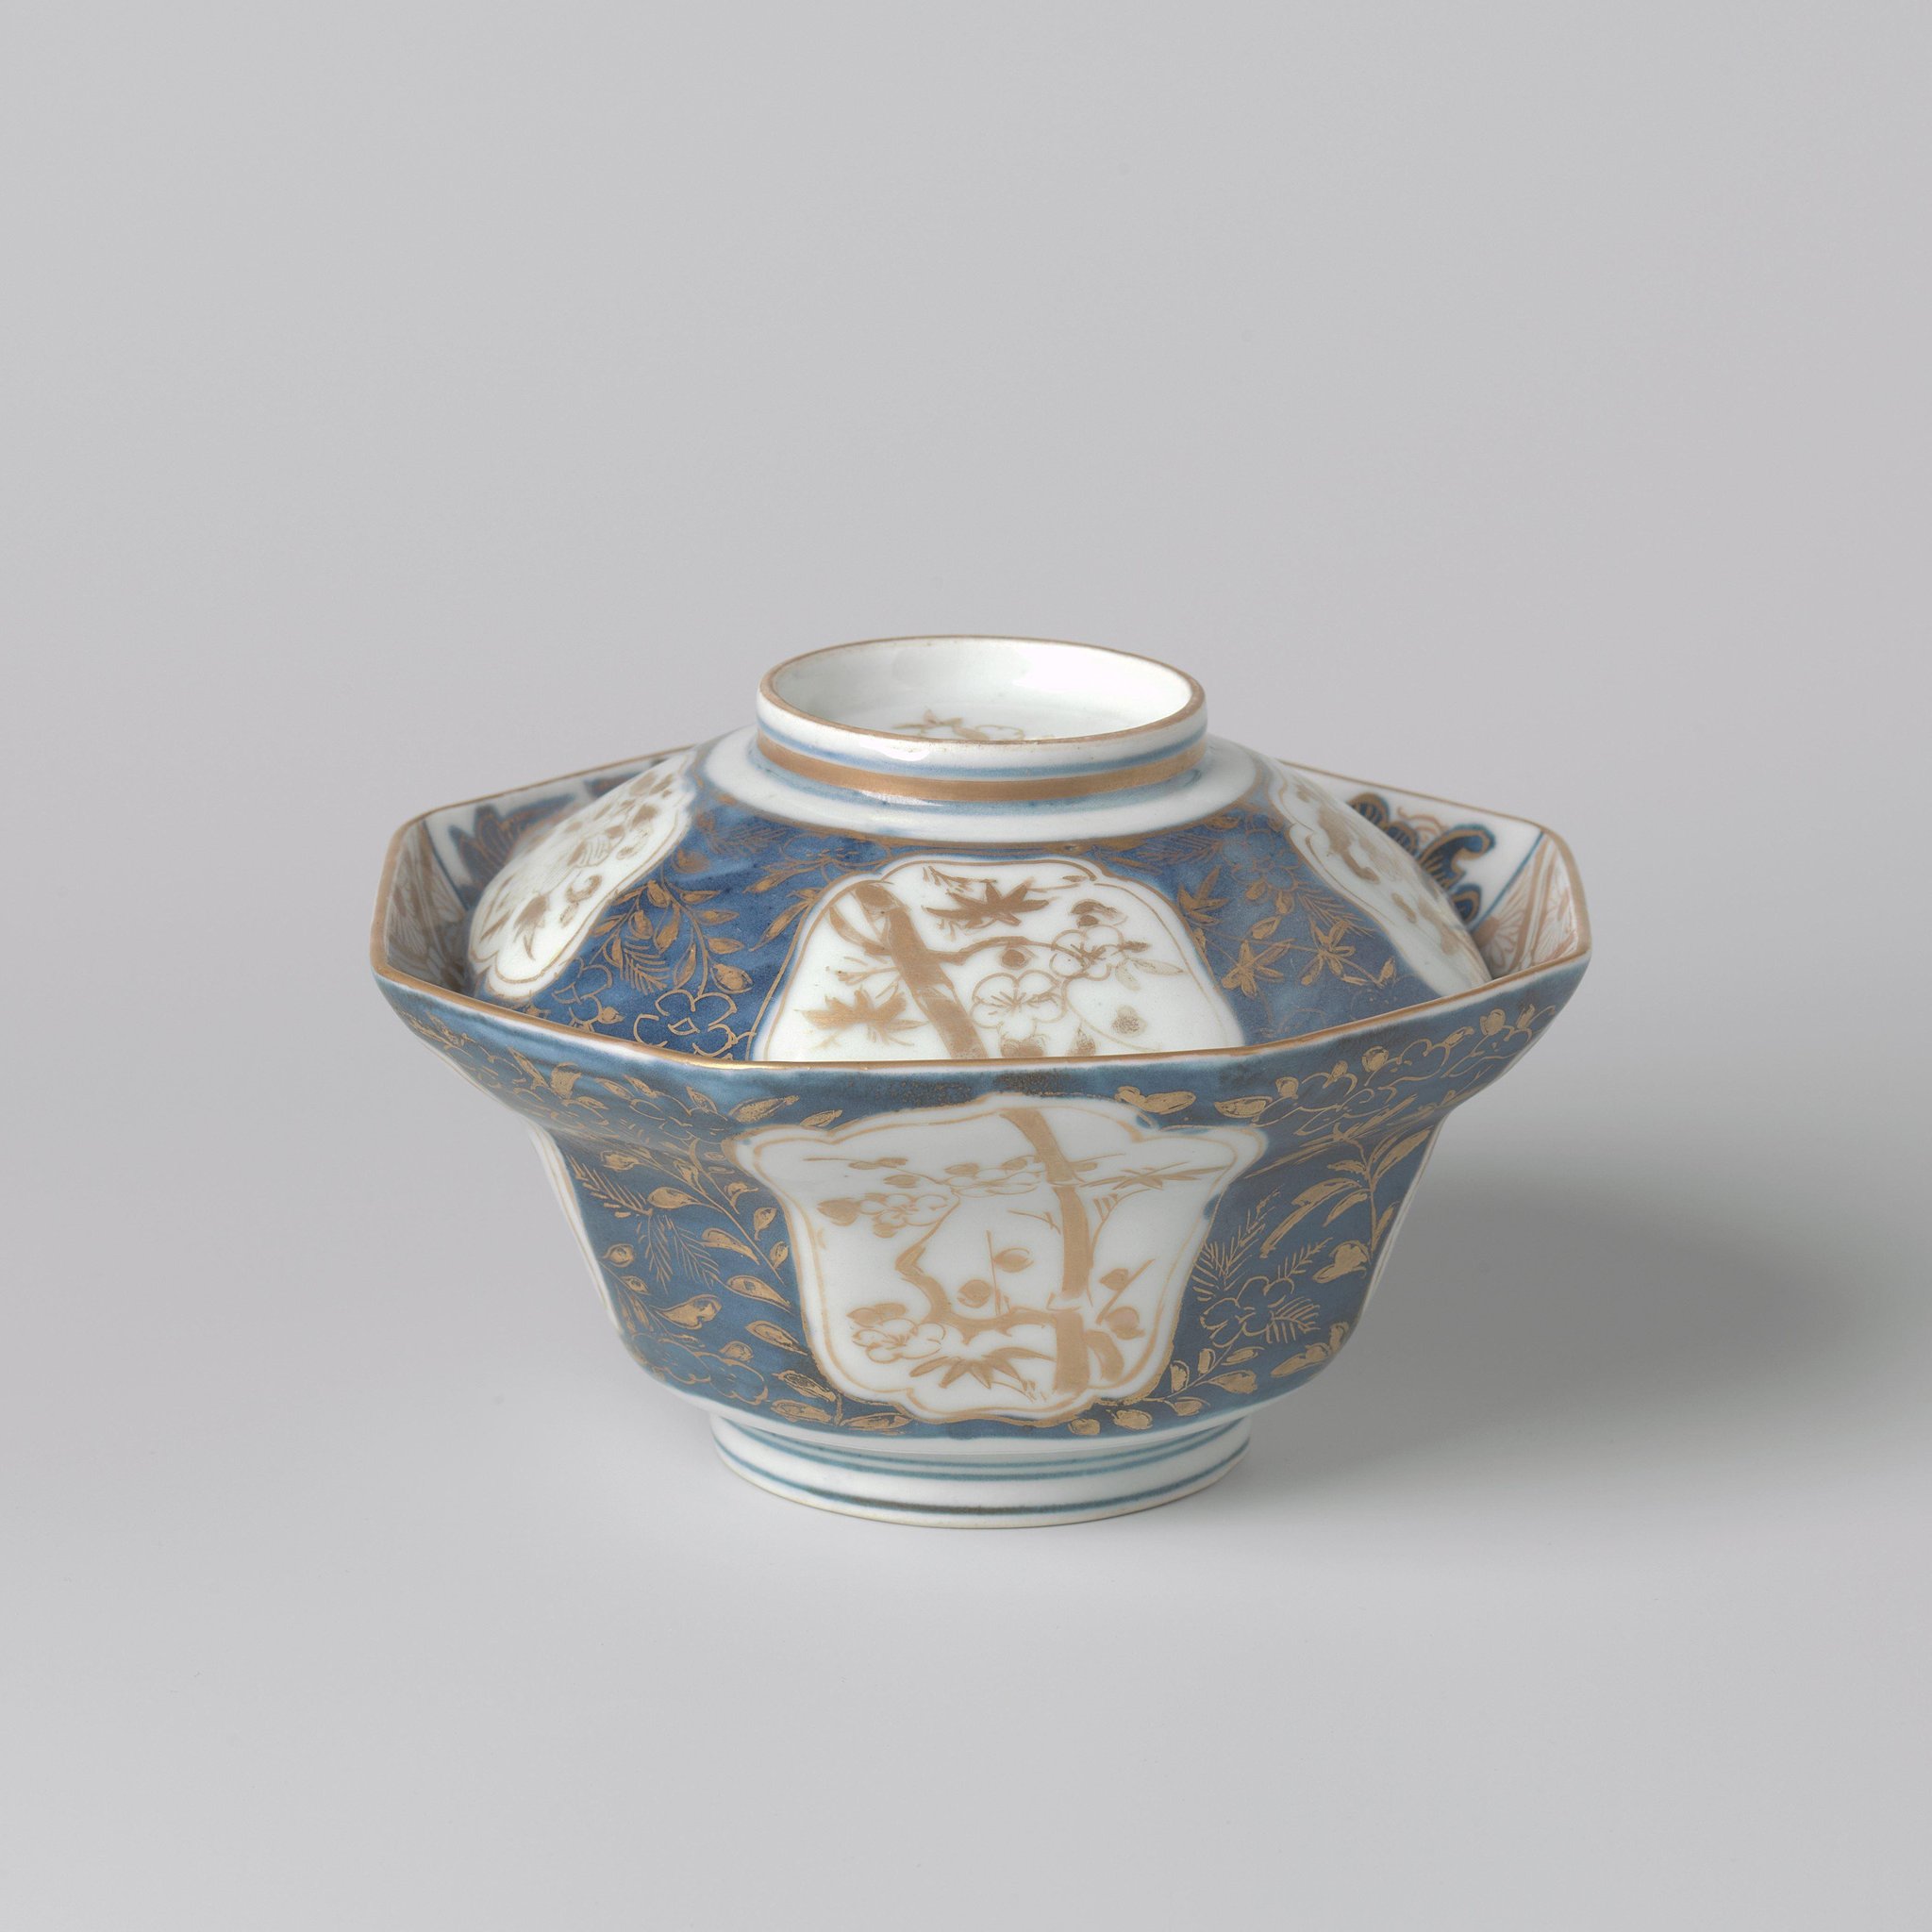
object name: bowl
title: Octagonal covered bowl with flowering plants in panels and flower sprays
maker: Anonymous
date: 1700-1799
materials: cobalt, glaze, gold, paint, porcelain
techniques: firing, gilding, turning, vitrification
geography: japan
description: Achtkantige, klokvormige dekselkom van porselein, beschilderd in onderglazuur blauw en op het glazuur goud. De buitenzijde van de kom is bedekt met onderglazuur blauw met daarop bloemtakken in goud. Daarin uitgespaard vier geschulpte cartouches met bloeiende planten (prunus, bamboe) en een gestileerde pioen. Op de bodem een bloemenvaas. De binnenrand met acht vakken met gestileerde bloemen en bloemranken. Imari.